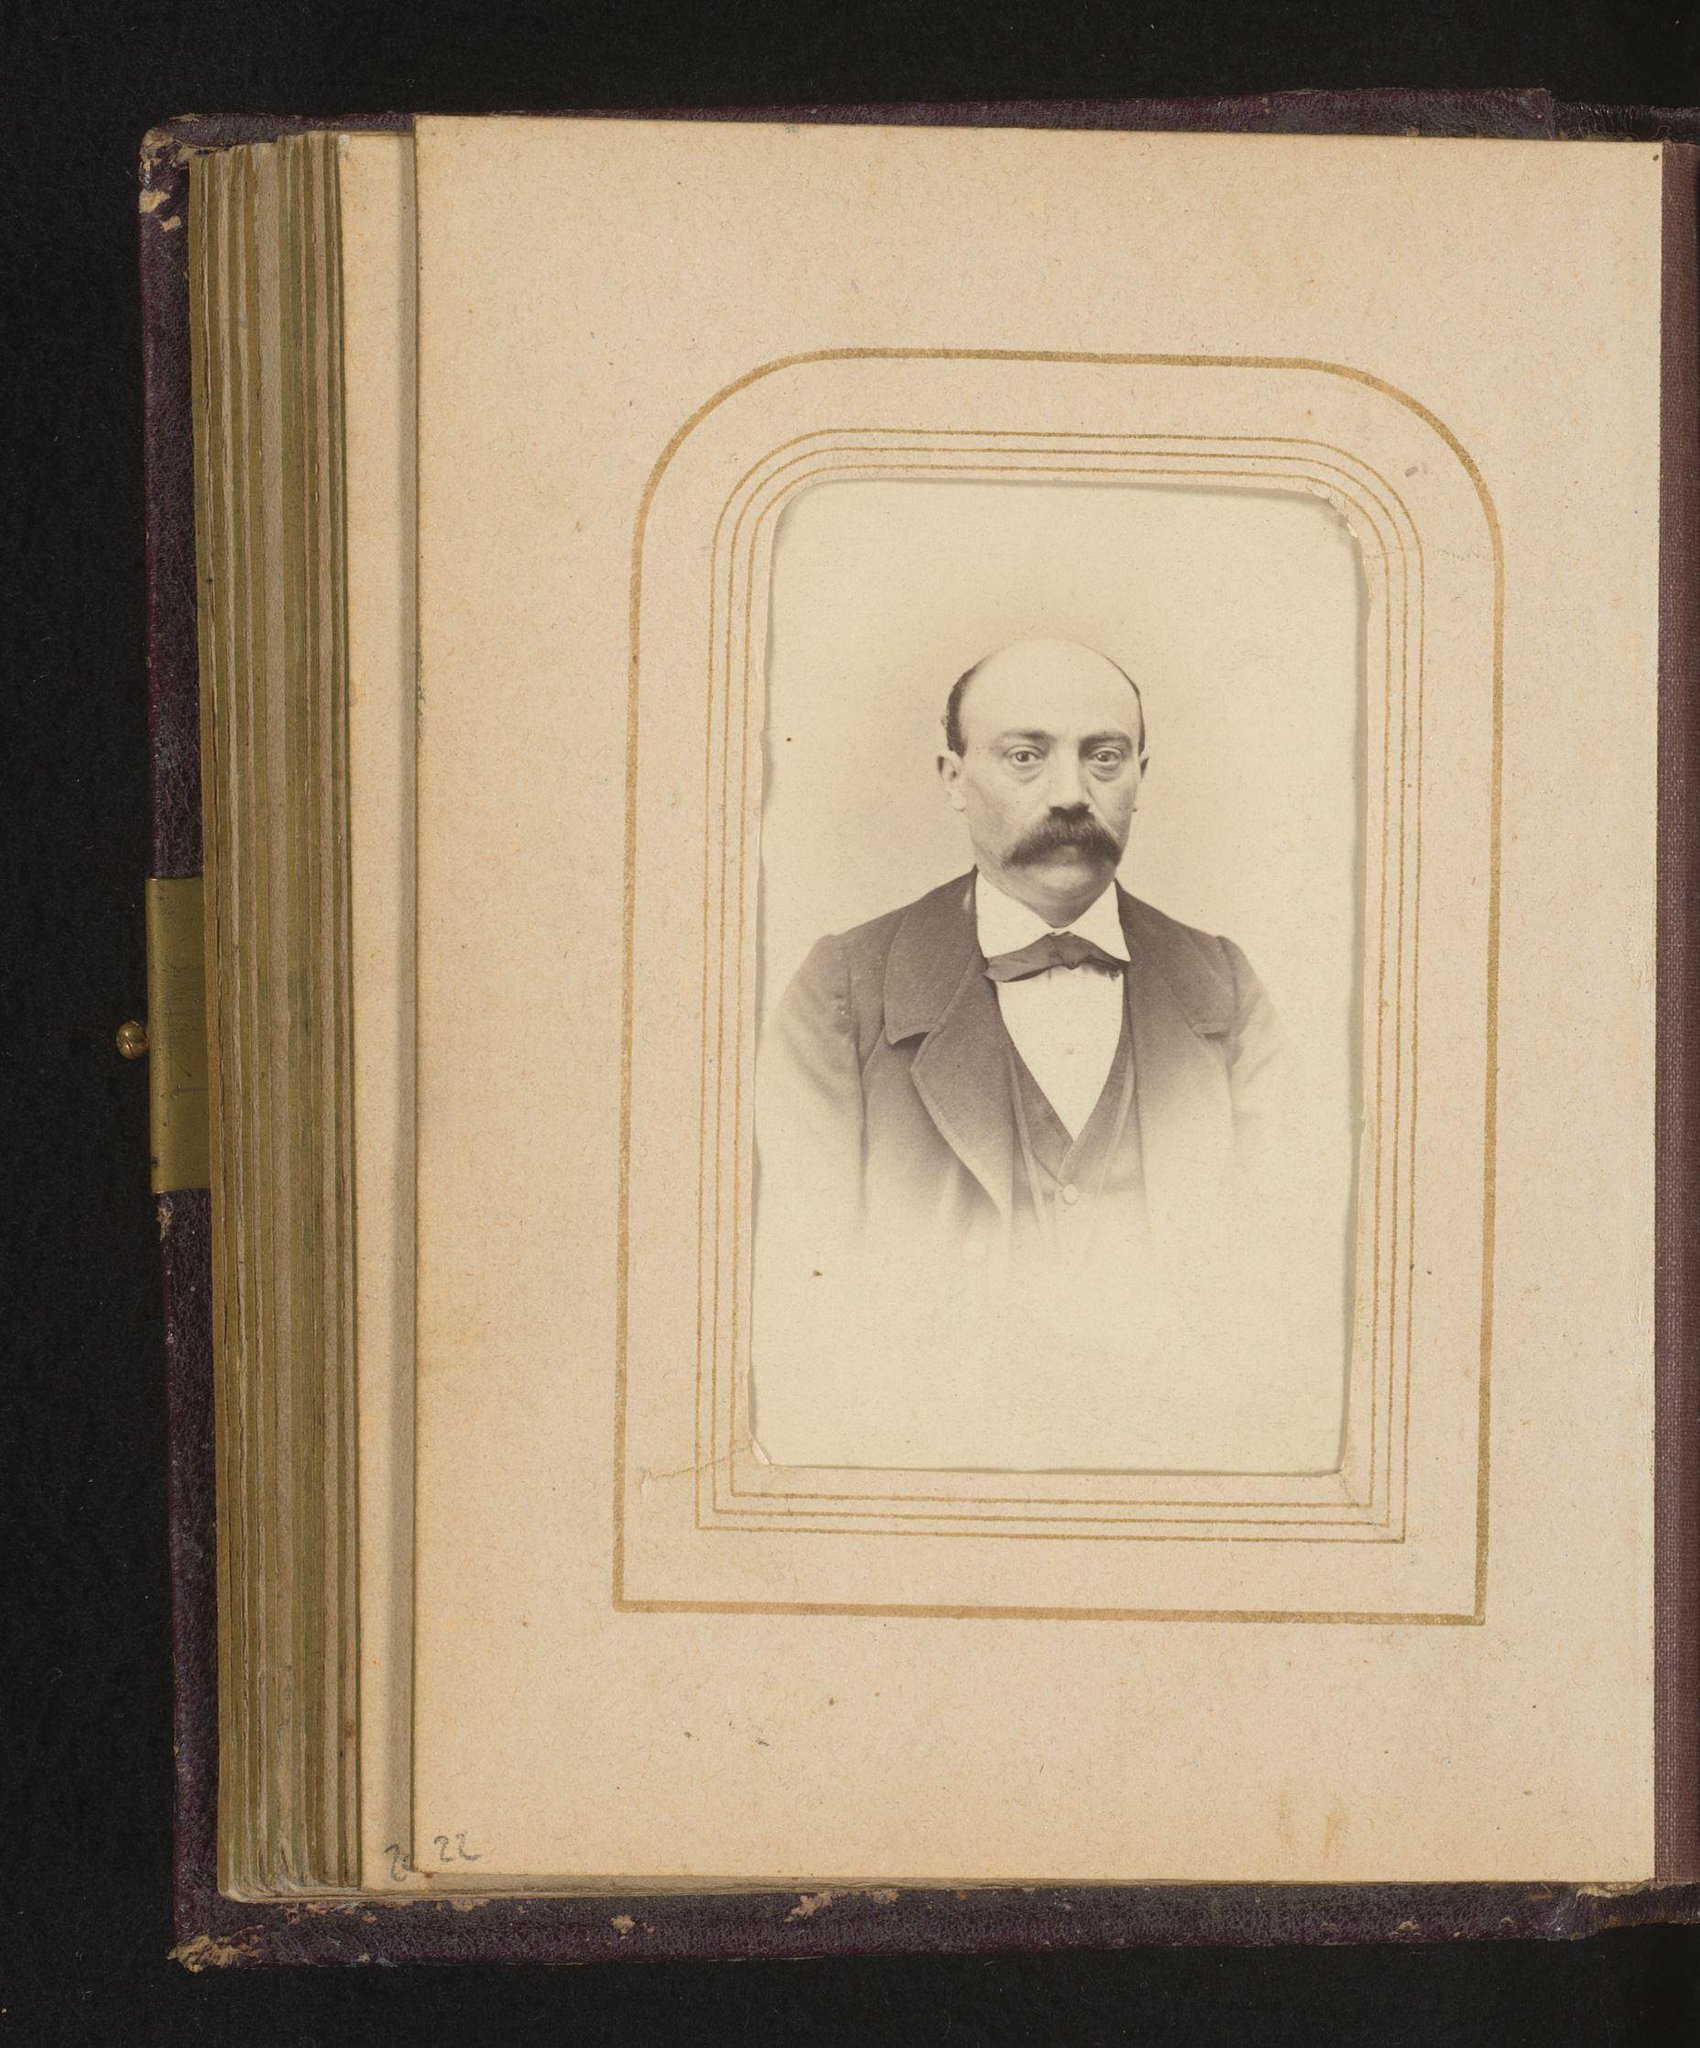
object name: carte de visite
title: Portret van een man met snor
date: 1860-1900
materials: cardboard, photographic support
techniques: albumen print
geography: valencia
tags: moustache, historical persons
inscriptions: inscription: ‘Ludovisi y su señora/ Fotografos Romanos/ Caballeros, 24/ Valencia’